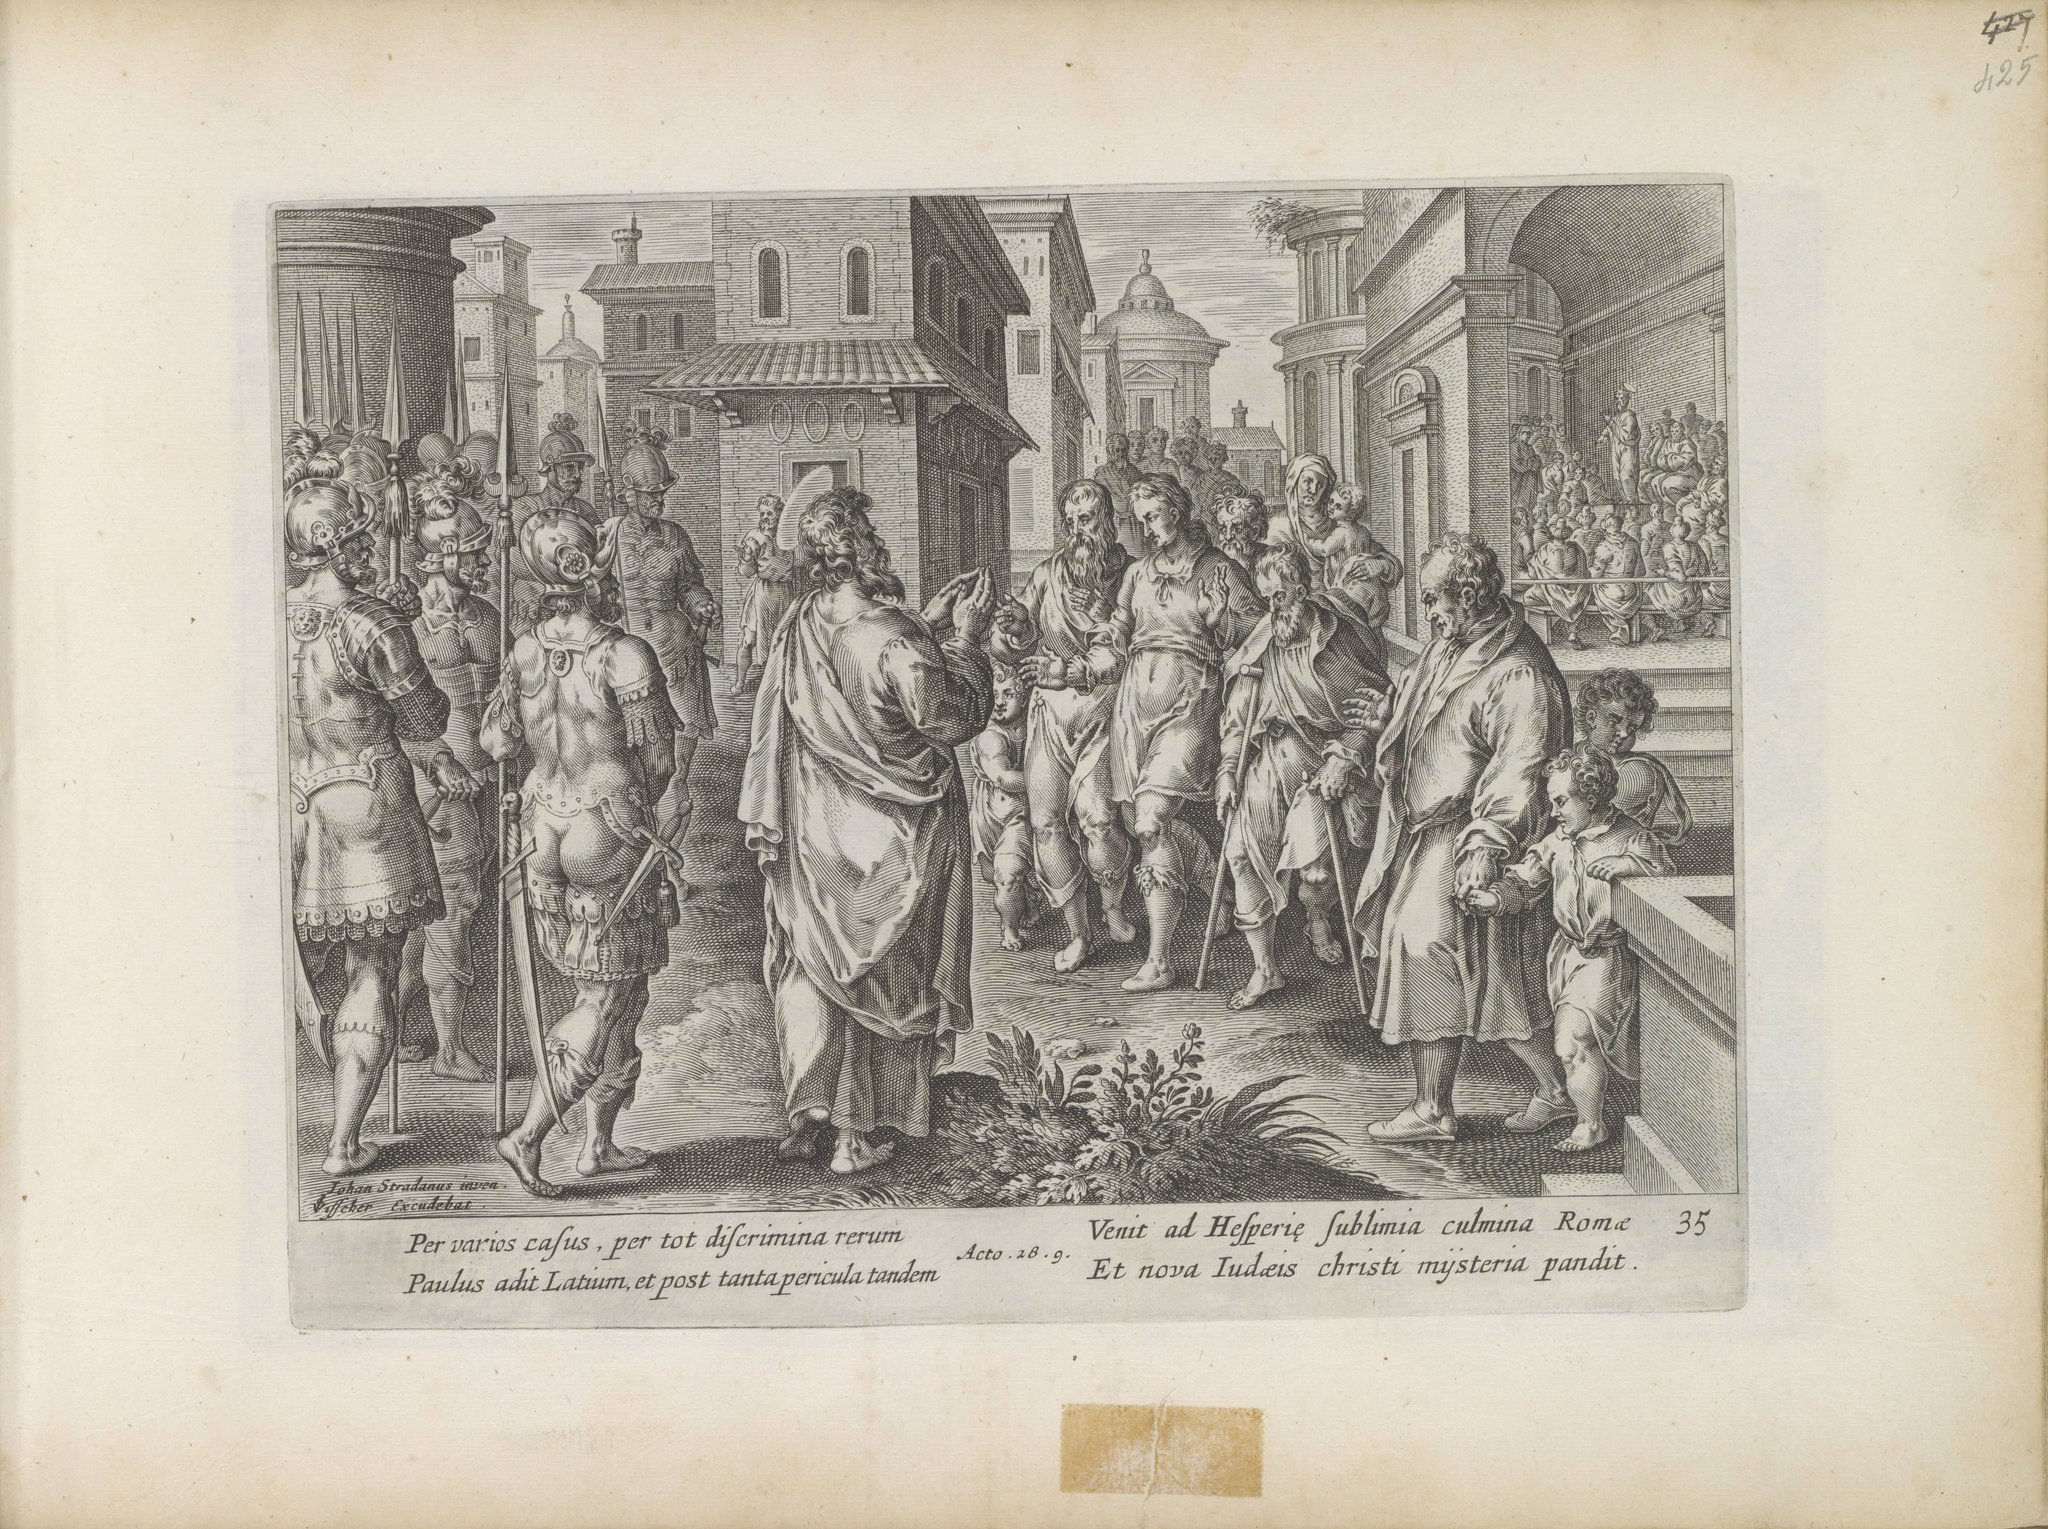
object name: album leaf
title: Theatrum Biblicum Hoc Est Historiae Sacrae Veteris et Novi Testamenti Tabulis Aeneis Expressae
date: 1643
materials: paper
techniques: engraving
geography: amsterdam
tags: paul preaches and tells his story to jews while guarded by soldiers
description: De apostel Paulus predikt de leer van Christus in Rome. Allerlei mensen luisteren naar hem. Soldaten bewaken Paulus. Onder de voorstelling een verwijzing in het Latijn naar de Bijbeltekst in Hand. 28:9. Deze prent maakt deel uit van een album.